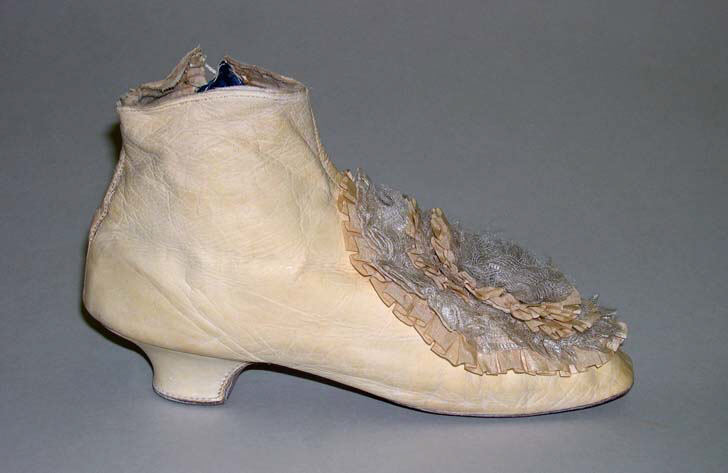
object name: shoe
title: Shoes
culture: italian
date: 1860-1879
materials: leather